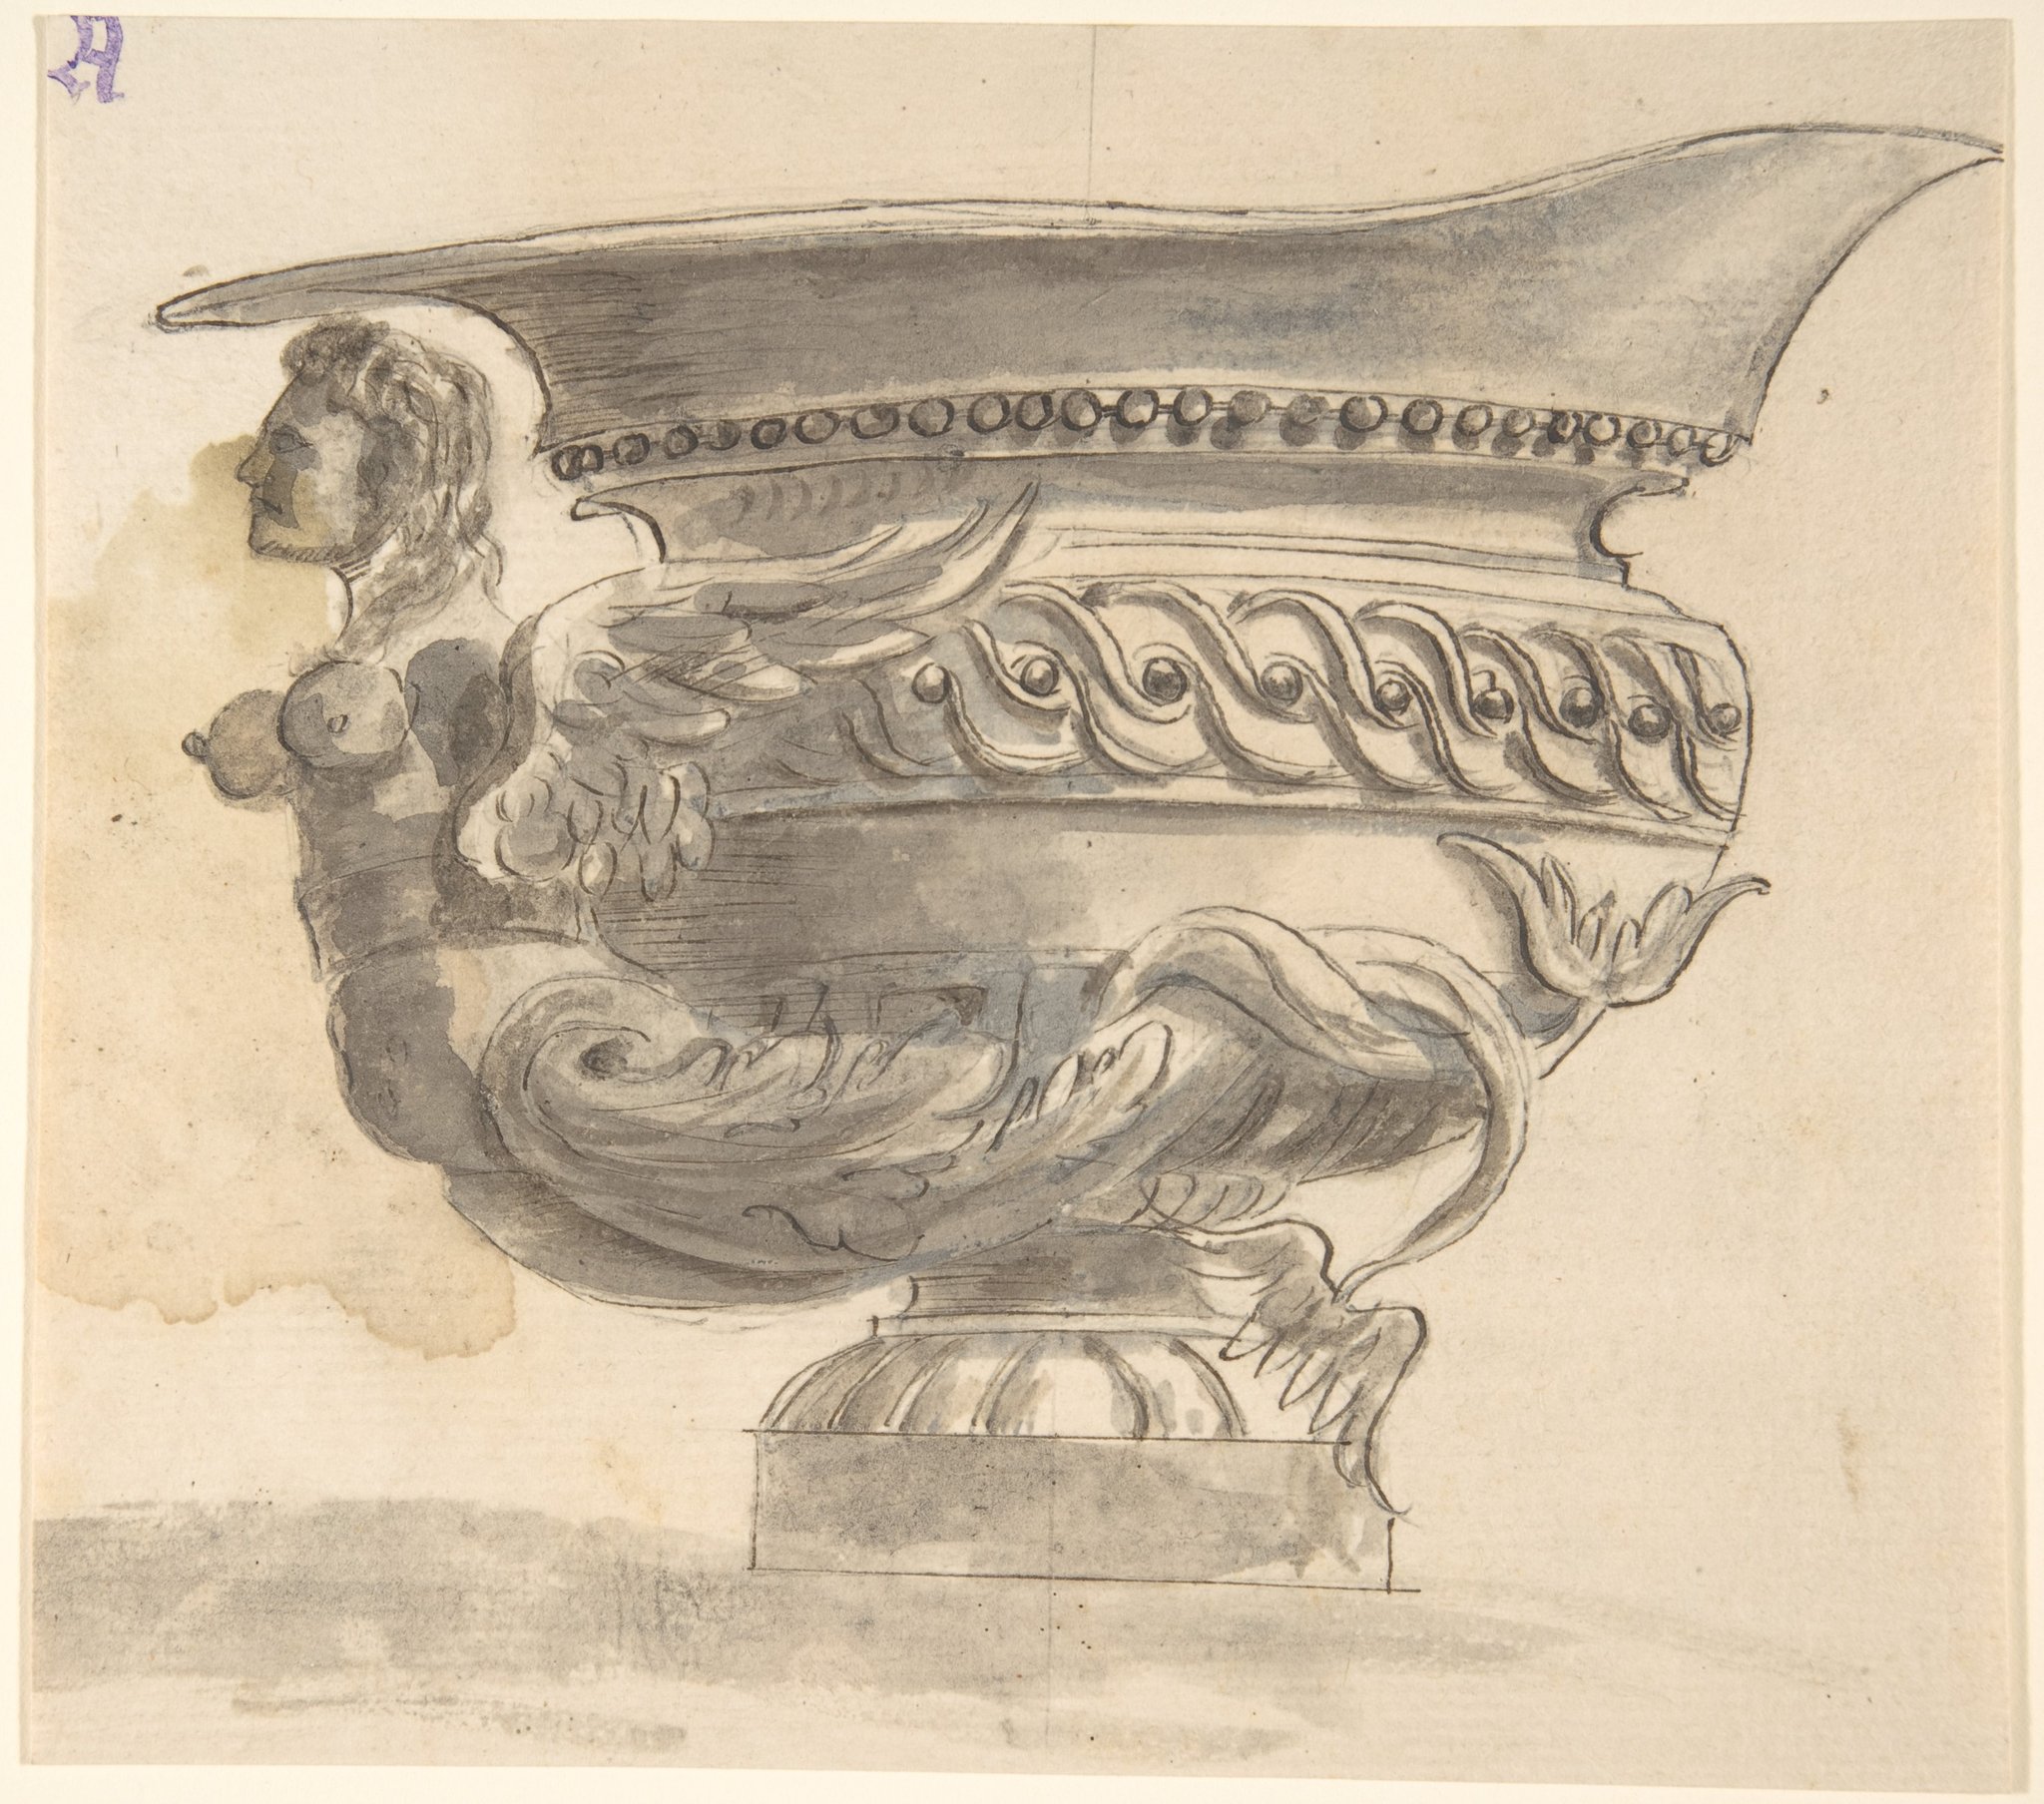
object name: drawing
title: Architectural Drawings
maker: anonymous, italian, 19th century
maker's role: artist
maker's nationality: italian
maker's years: 1800-1900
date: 1800-1900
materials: ink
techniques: brush, pen, wash